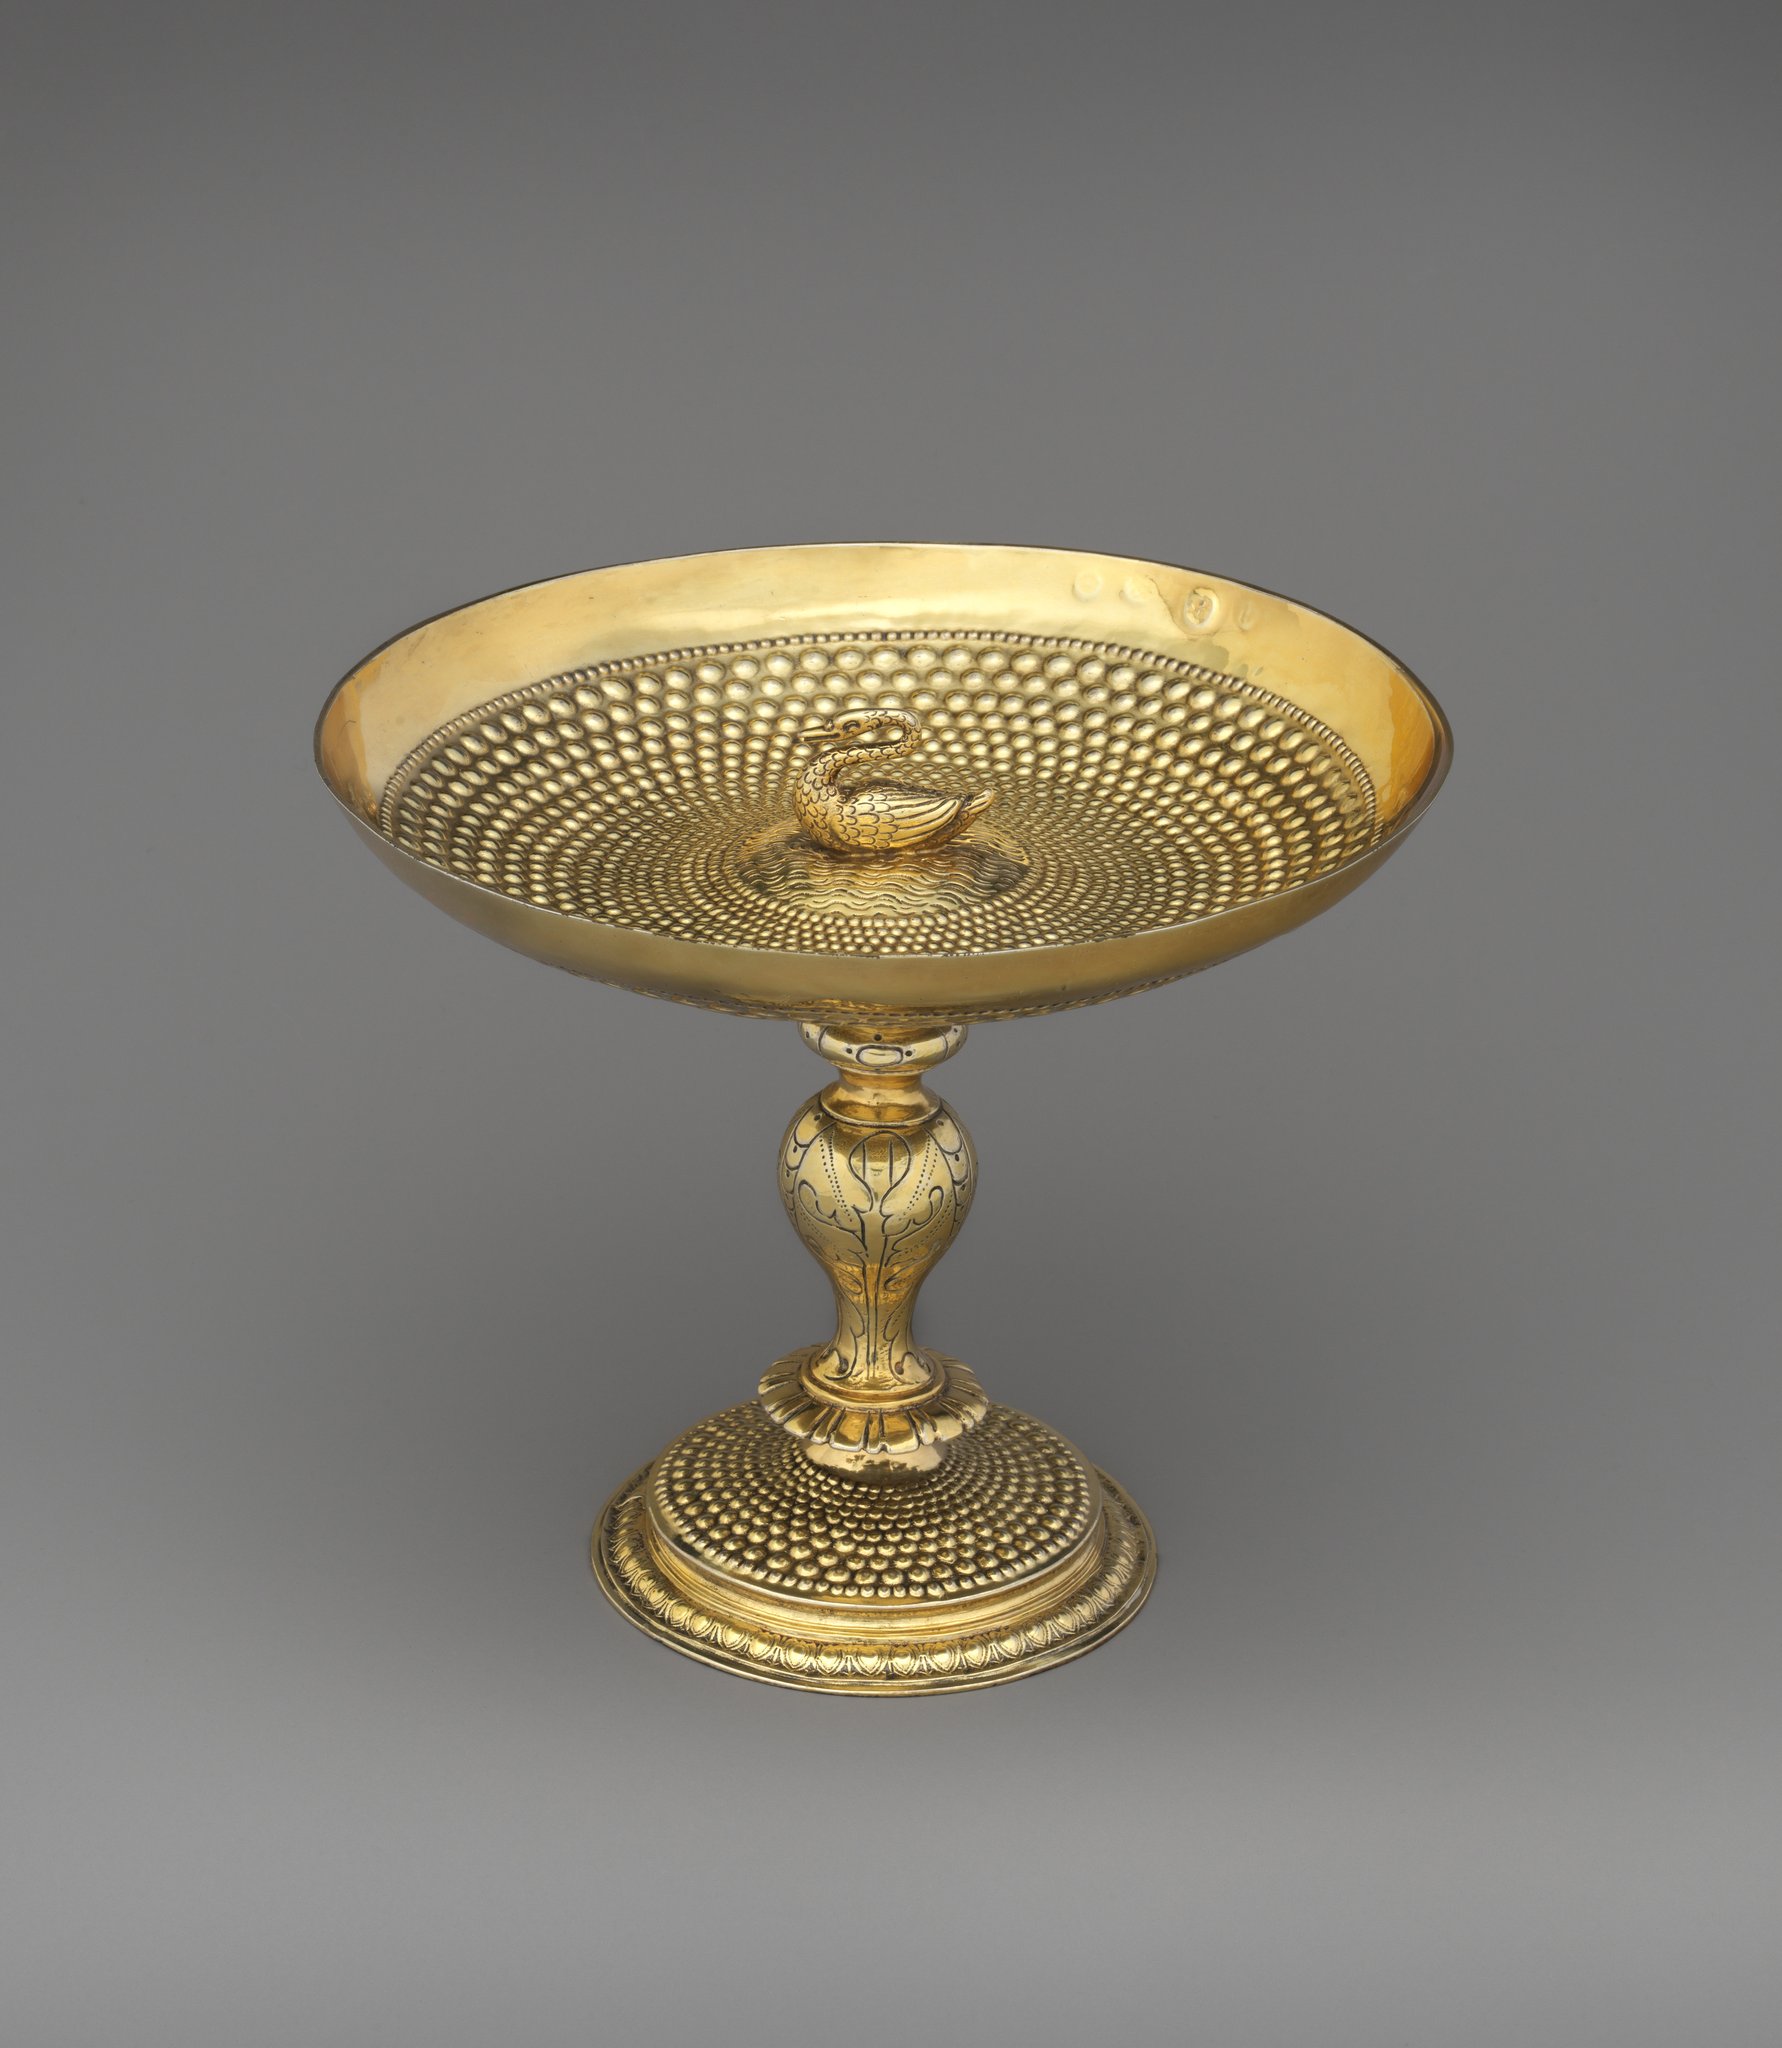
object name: wine cup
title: Wine Cup on a High Foot (Tazza)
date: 1599-1600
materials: gilt silver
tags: swans